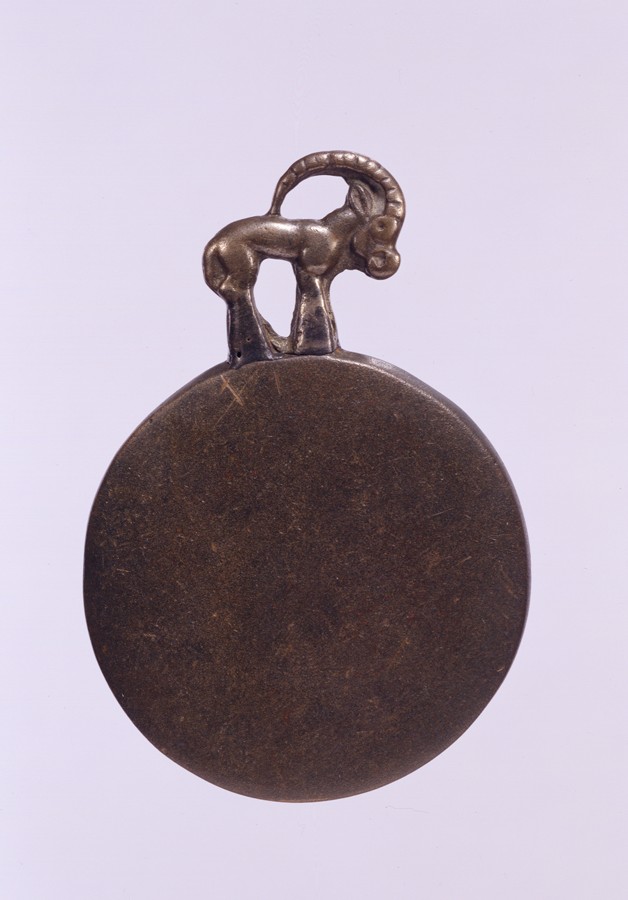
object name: mirror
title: Mirror with Ibex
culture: northwest chinese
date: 500-301 BCE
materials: bronze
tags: ibex